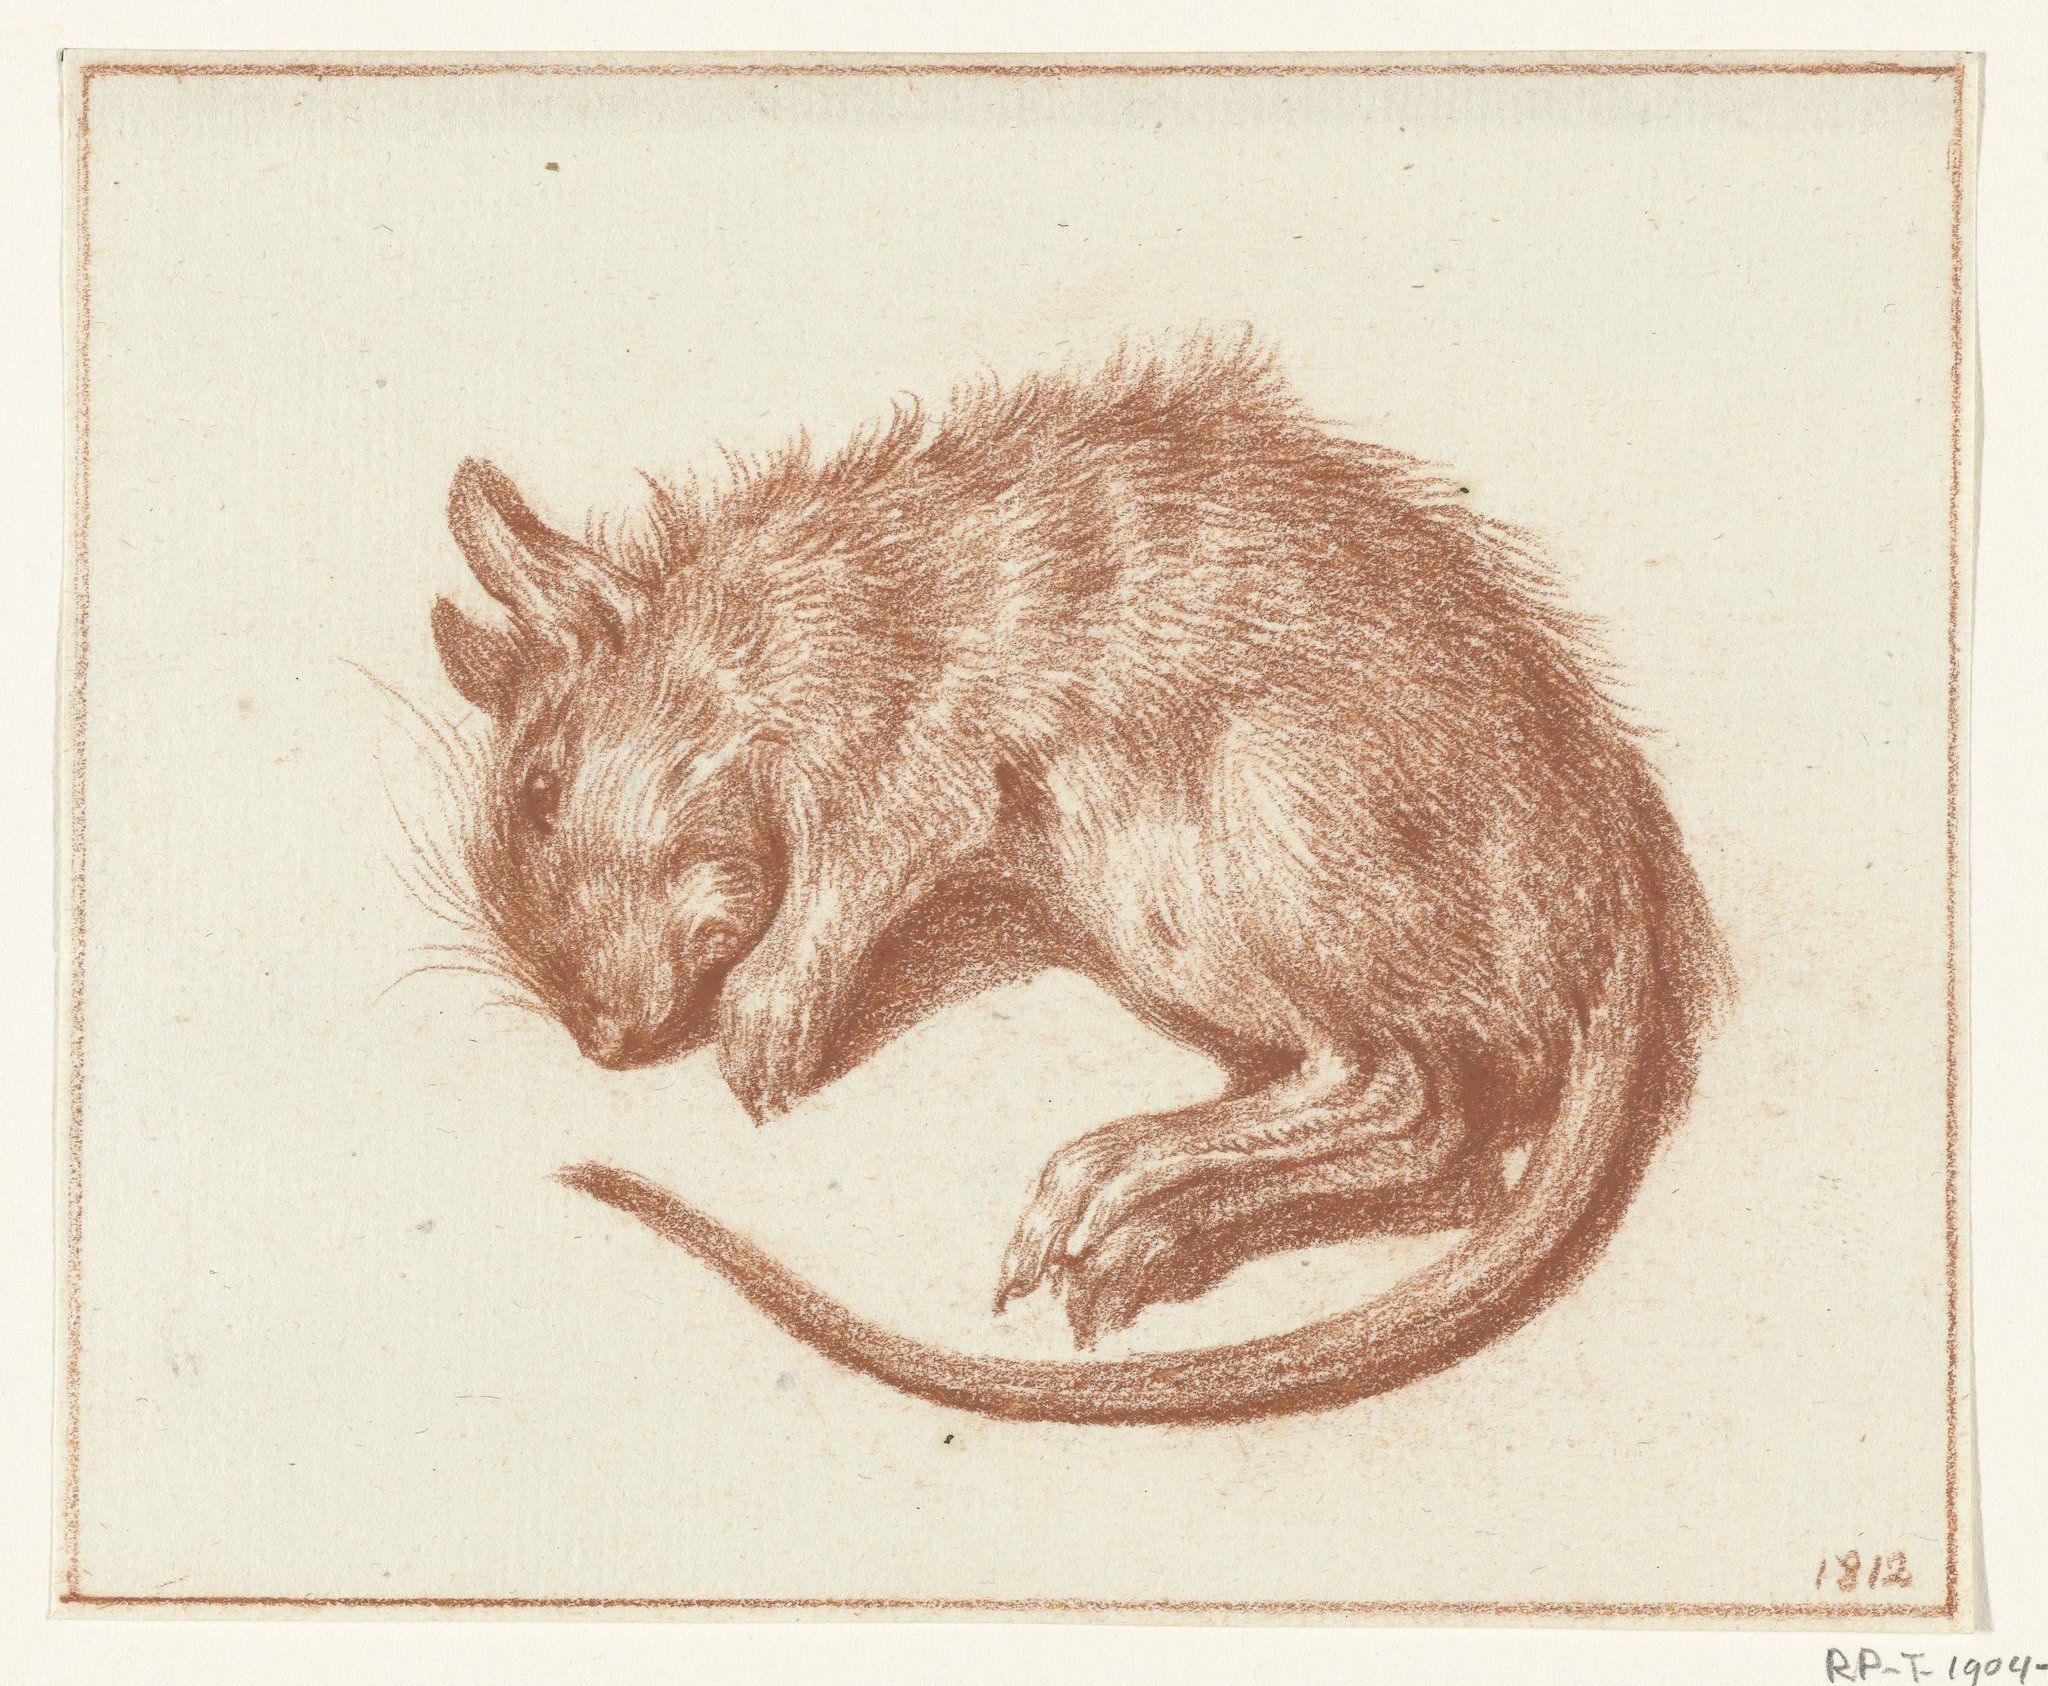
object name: drawing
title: Dode rat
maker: jean bernard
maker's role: draughtsman, print maker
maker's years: 1765-1833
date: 1812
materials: chalk, paper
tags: rodents: rat